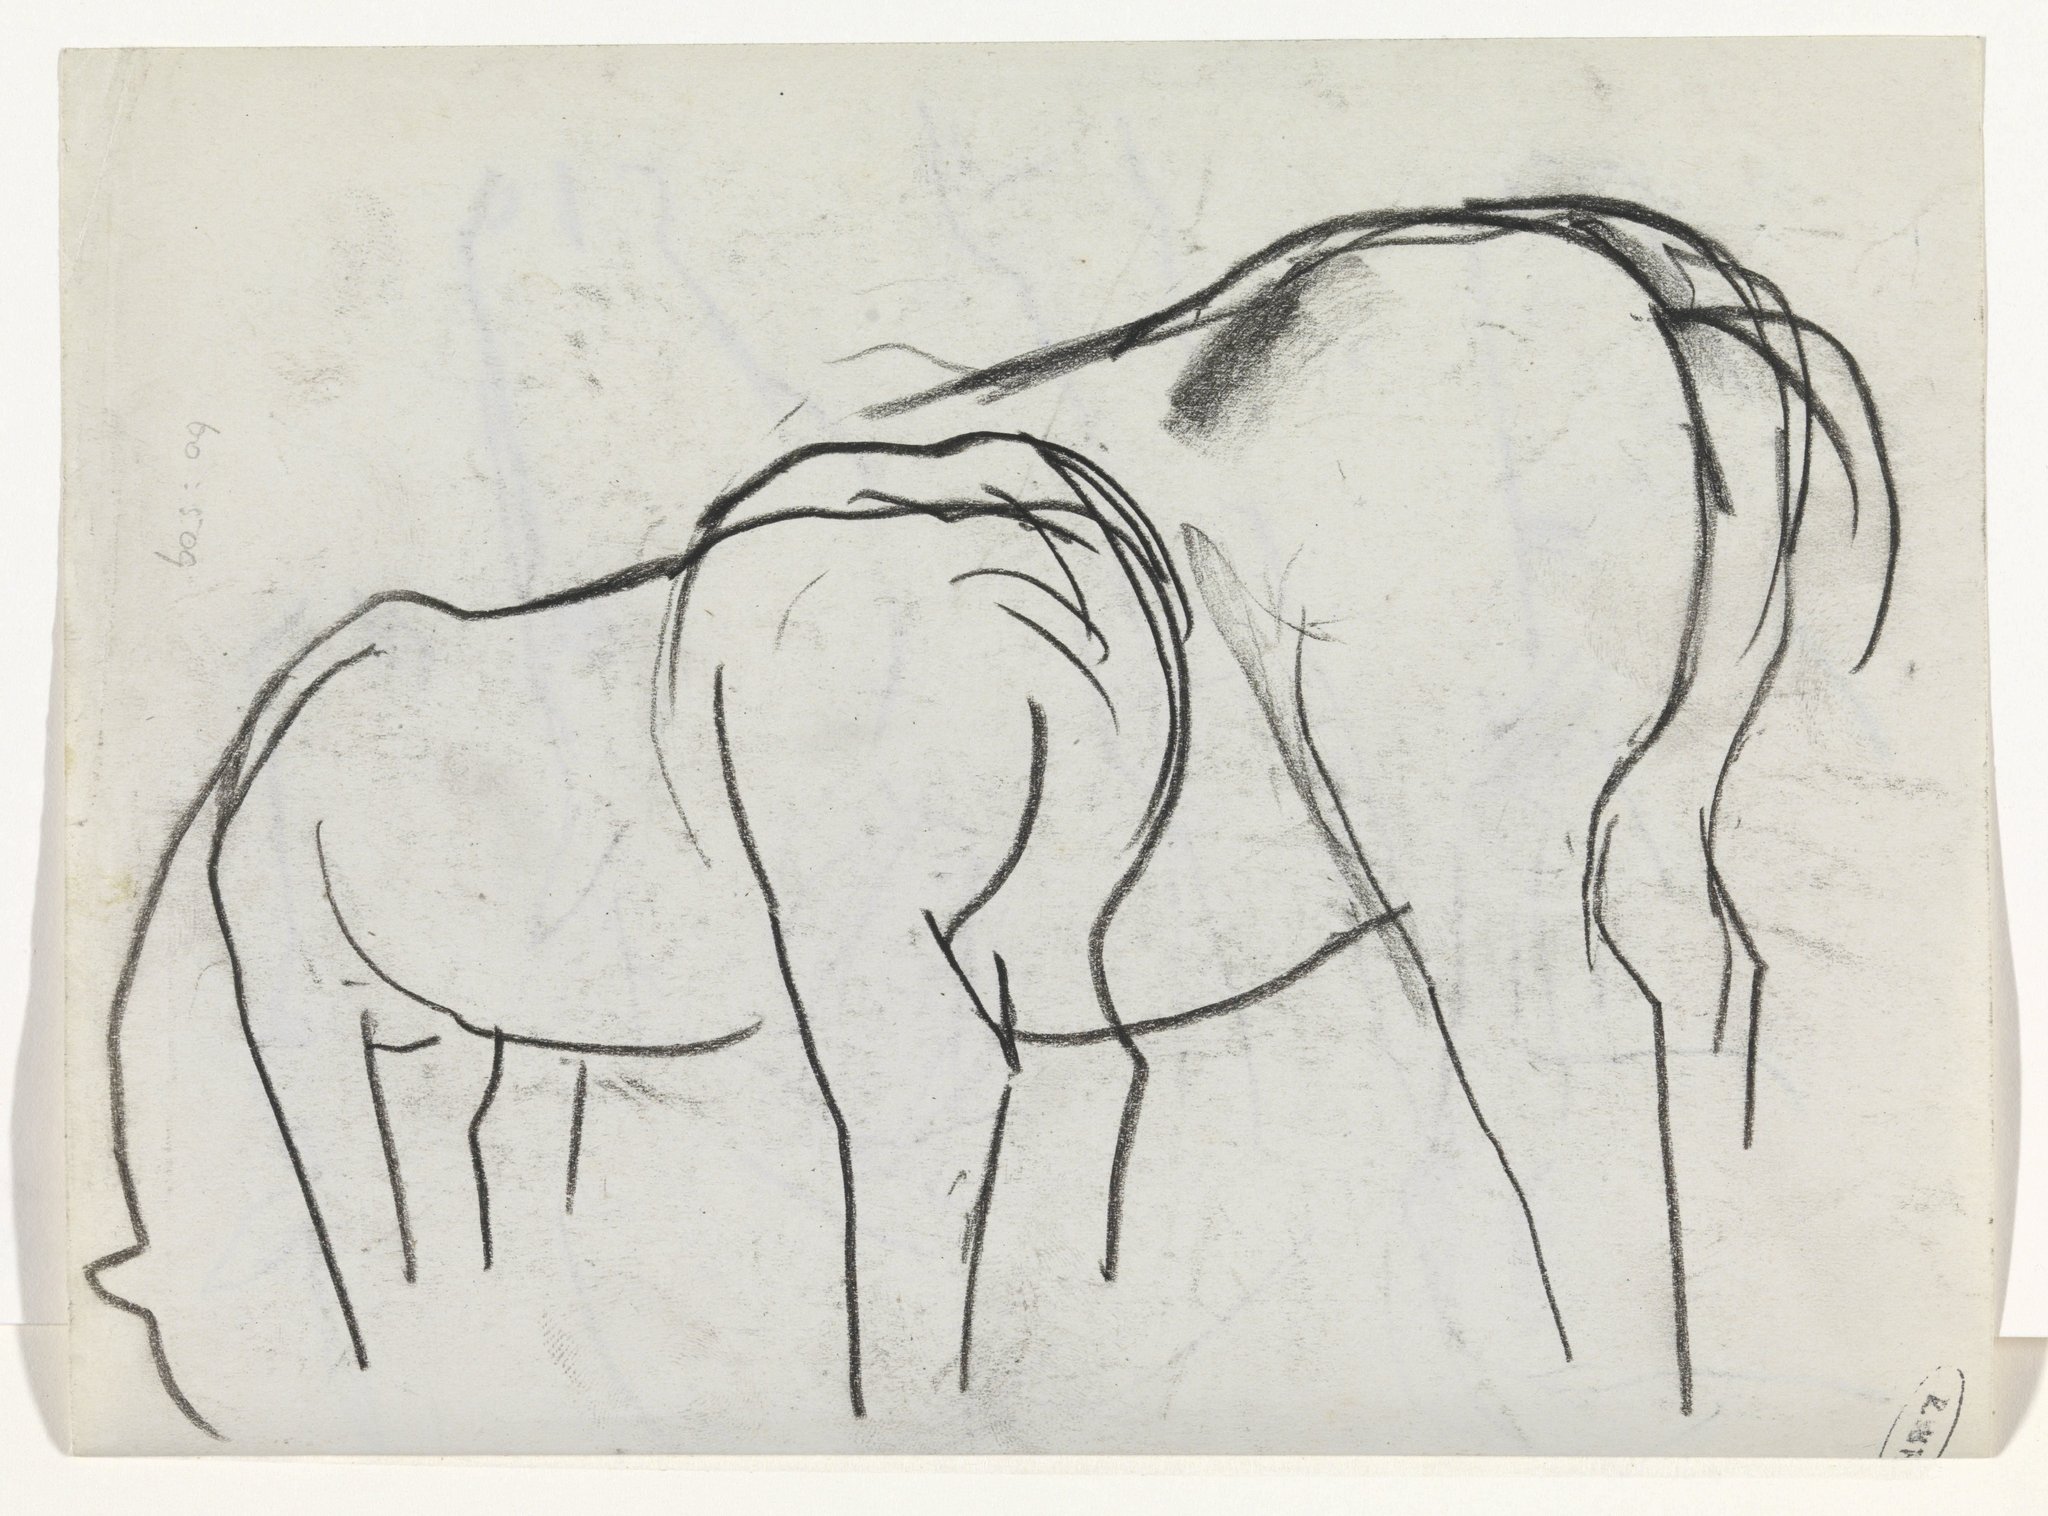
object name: drawing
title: Twee paarden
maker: leo gestel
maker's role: draughtsman, print maker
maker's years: 1881-1941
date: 1891-1941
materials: chalk, paper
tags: horse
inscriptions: collector's mark: Lugt 2228